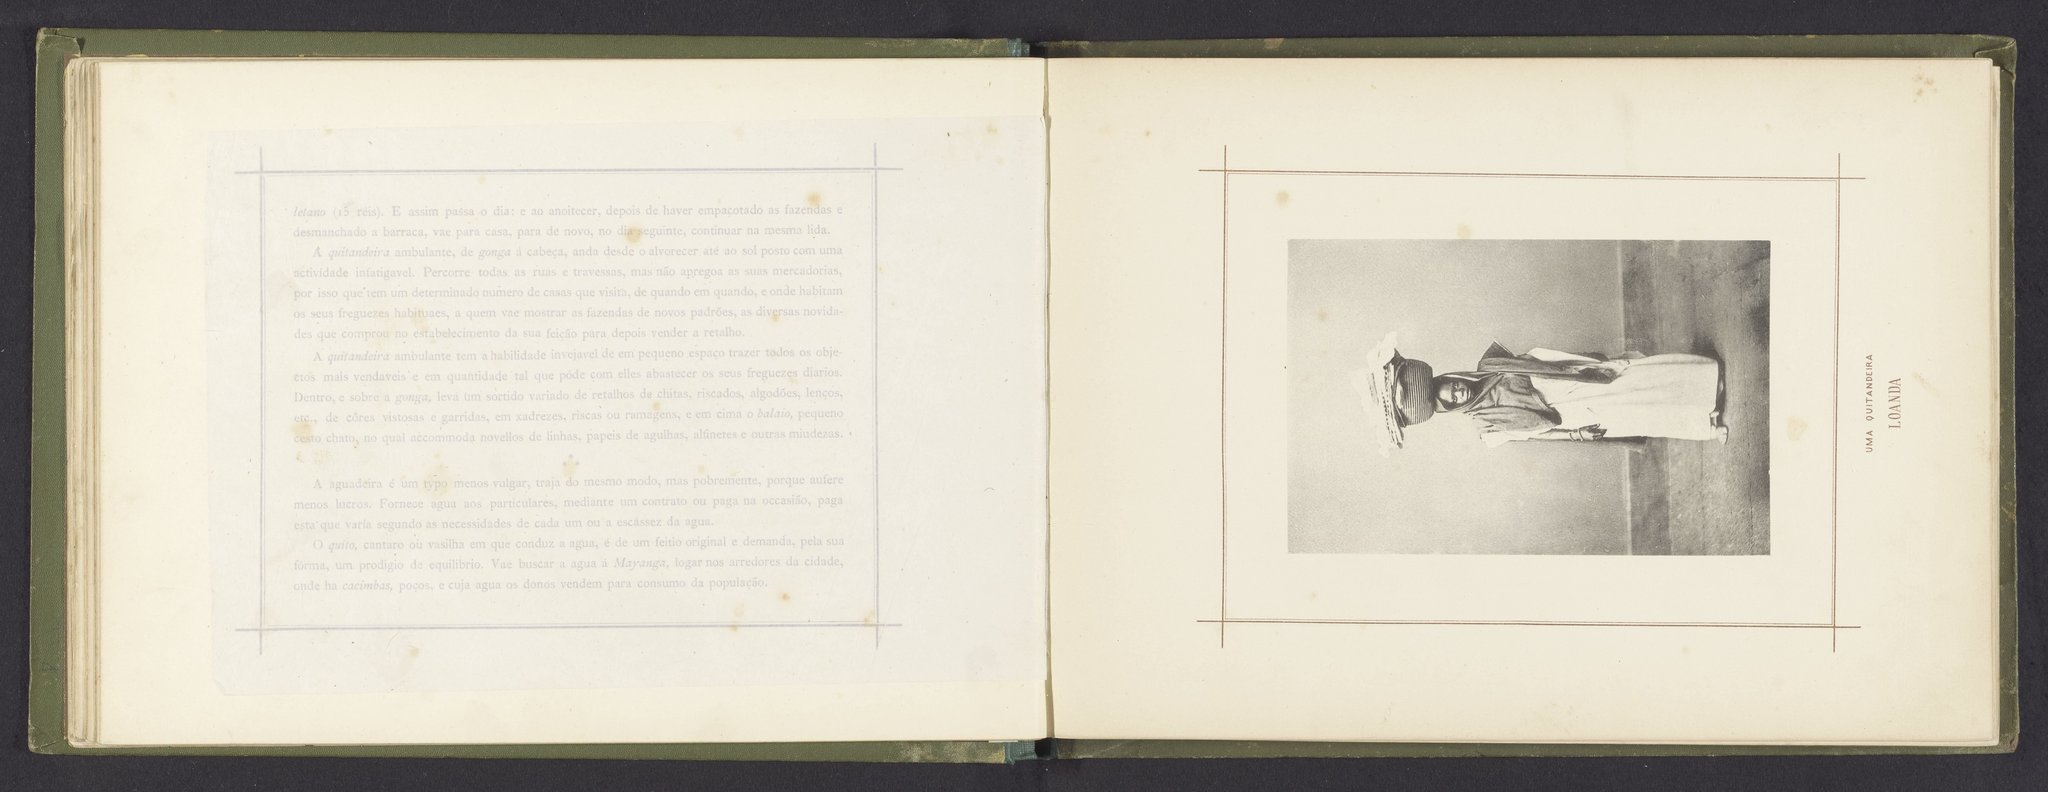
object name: page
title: Loanda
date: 1876-1886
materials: paper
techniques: photograph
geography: luanda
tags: container made of plant material other than wood: basket, merchant, salesman - bb - women engaged in trade and commerce